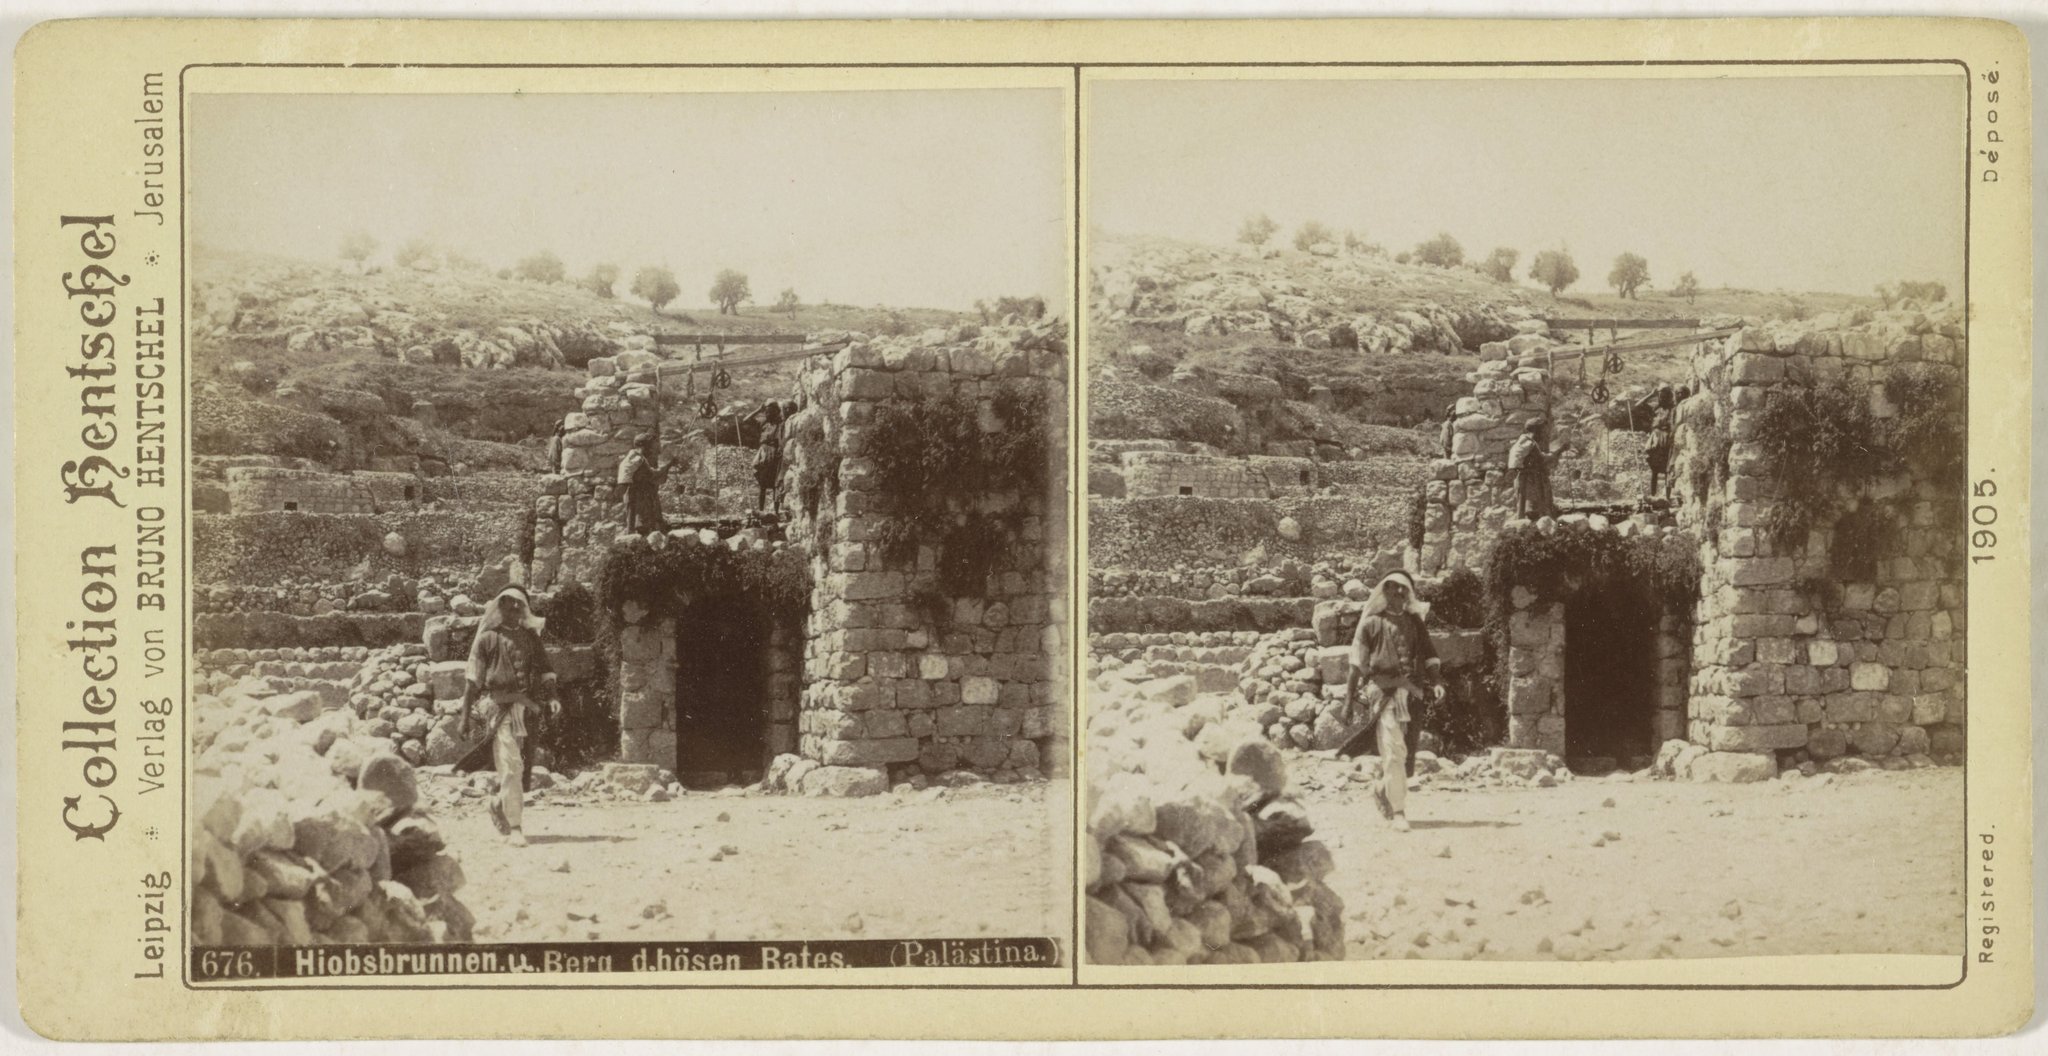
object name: stereograph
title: Bron van Rogel, Jeruzalem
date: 1905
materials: cardboard, paper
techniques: albumen print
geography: en rogel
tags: well, en rogel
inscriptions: inscription: ‘Déposé.’, number: ‘676.’, inscription: ‘Registered.’